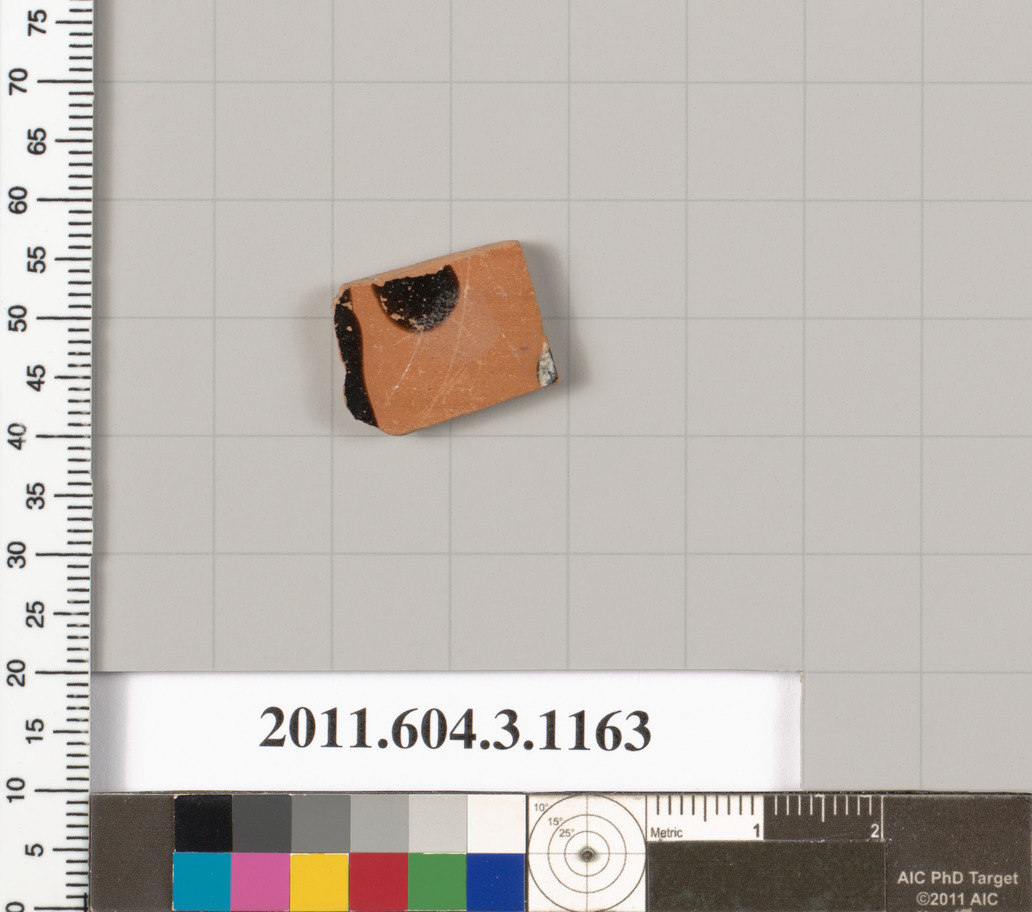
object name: mastoid or kyathos fragment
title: Terracotta fragment of a mastoid (drinking cup with narrow base) or a kyathos (cup-shaped ladle)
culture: greek, attic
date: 534-468 BCE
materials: terracotta